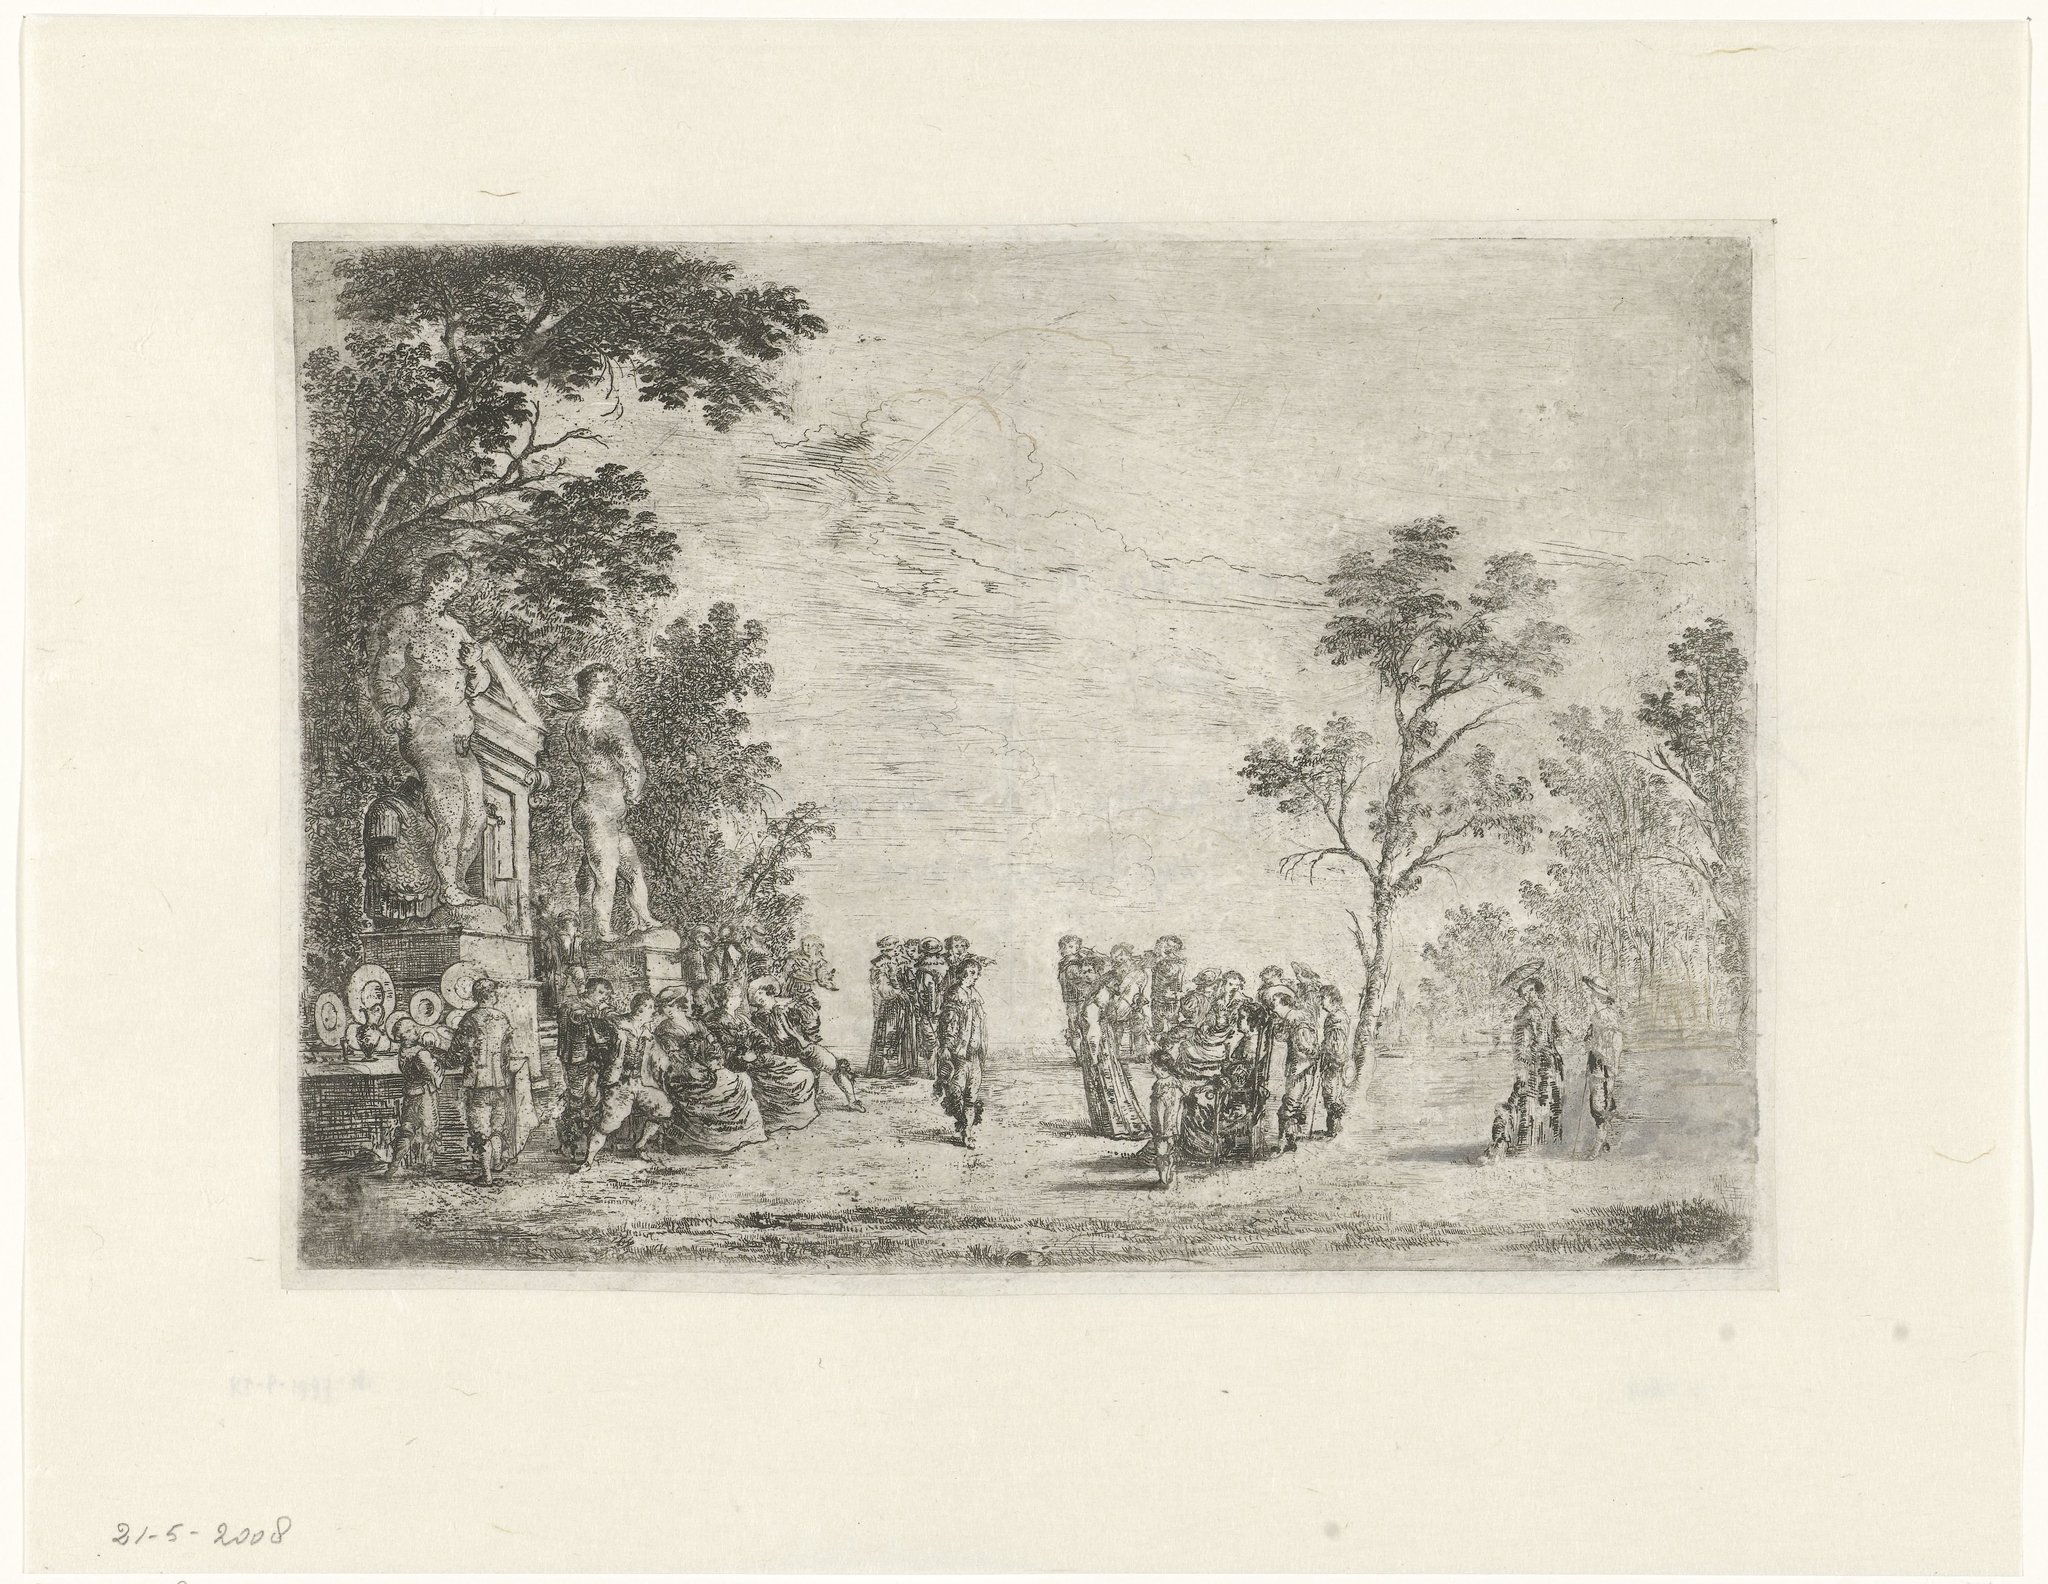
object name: print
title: Festival in een park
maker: jan fouceel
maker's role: print maker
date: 1665-1675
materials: ink, paper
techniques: brush, etching, pen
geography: antwerp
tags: park, one pair dancing; man and woman dancing as a couple, ornamental fountain, festivities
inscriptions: collector's mark: Lugt 2760, collector's mark: Lugt 2228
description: In een park zitten enkele fraai geklede dames en heren te drinken en te praten voor een architecturale fontein met twee grote beelden. Tegenover hen bevindt zich een tweede gezelschap. In het midden een dansend paar.